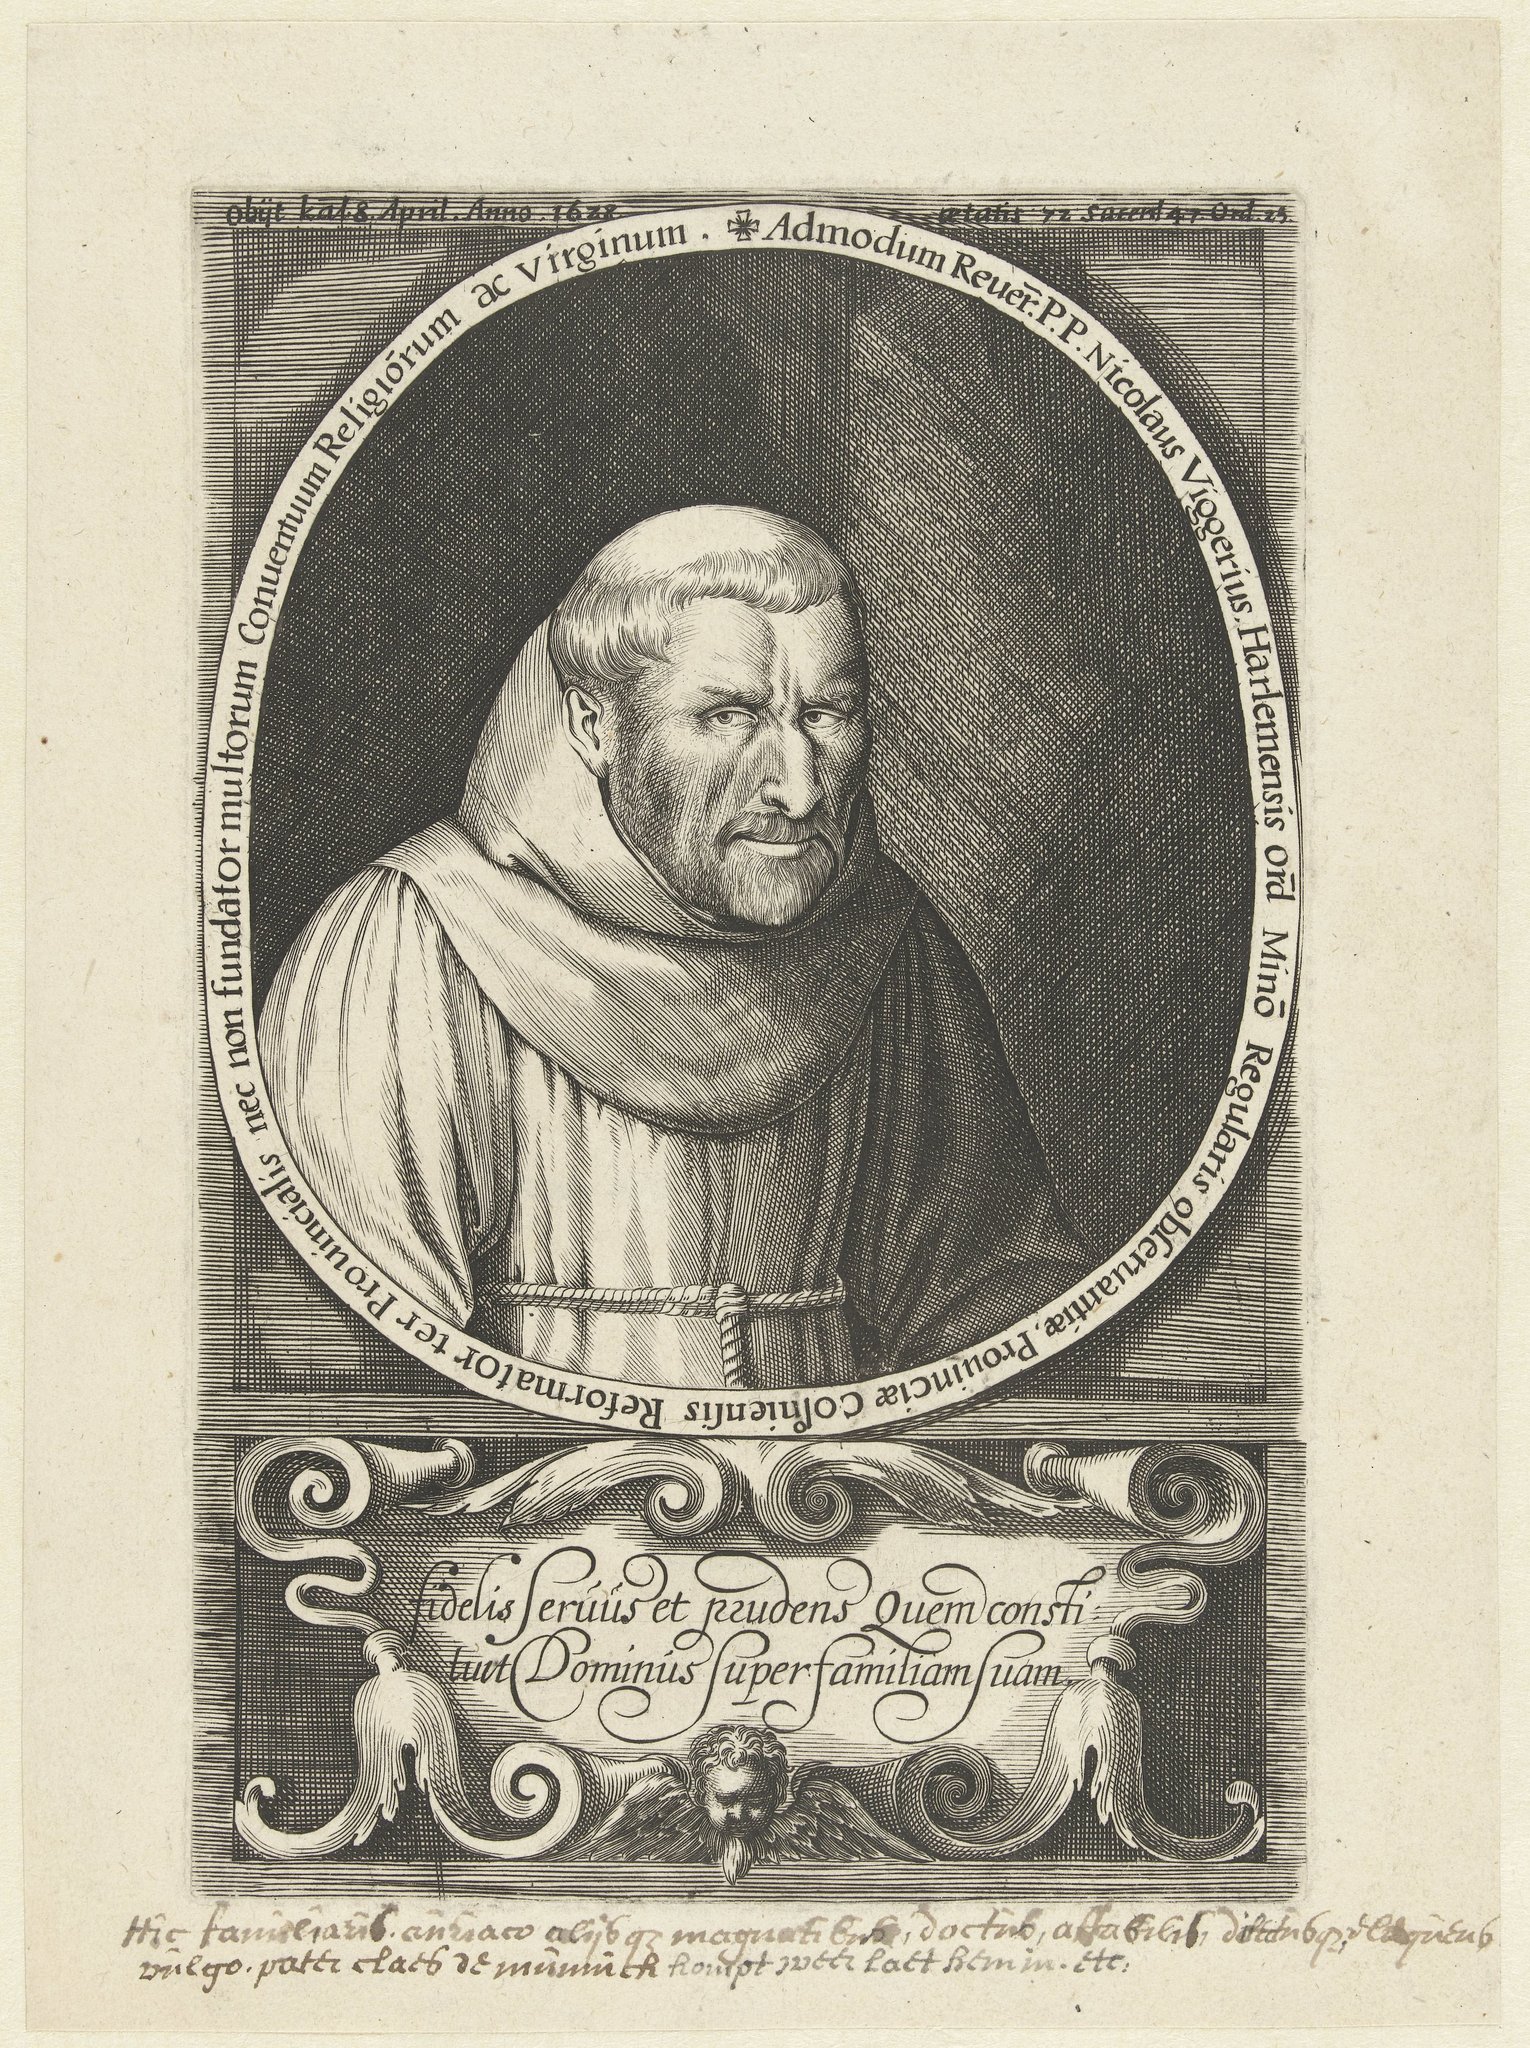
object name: print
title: Portret van Nicolaas Wigger als minderbroeder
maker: pieter fransz de grebber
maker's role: painter, print maker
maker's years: 1600-1653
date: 1628-1655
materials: paper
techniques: engraving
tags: priest, monks and nuns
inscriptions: collector's mark: Lugt 2228a, inscription: ‘moeilijk leesbaar’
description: Portret van Nicolaas Wigger als minderbroeder op medaillon met randschrift en een cartouche met een motto onder het portret. Volgens het opschrift sloot hij zich op 8 april 1628 aan bij de orde van de minderbroeders in het Sint Jacobsgodshuis te Haarlem.